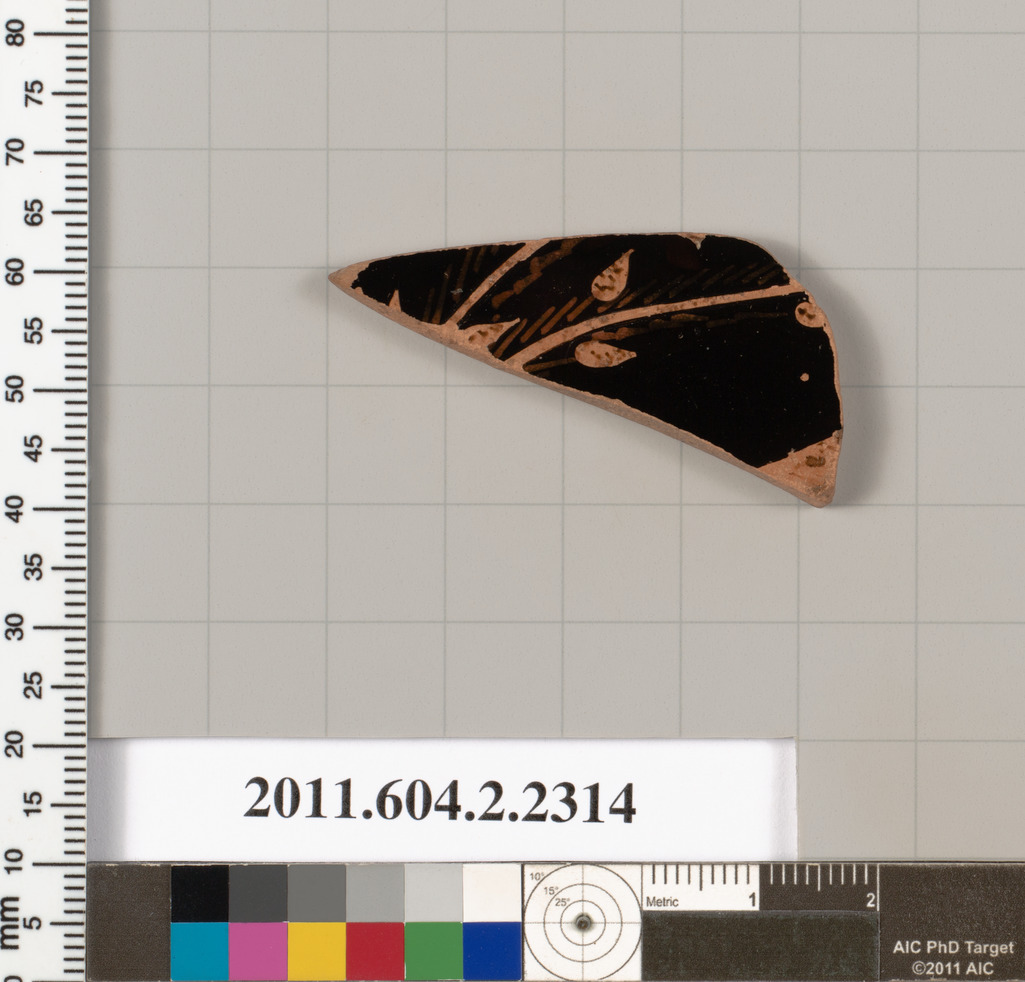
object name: pot fragment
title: Terracotta fragment of a pot; unglazed on the inside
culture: greek, attic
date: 475-451 BCE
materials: terracotta